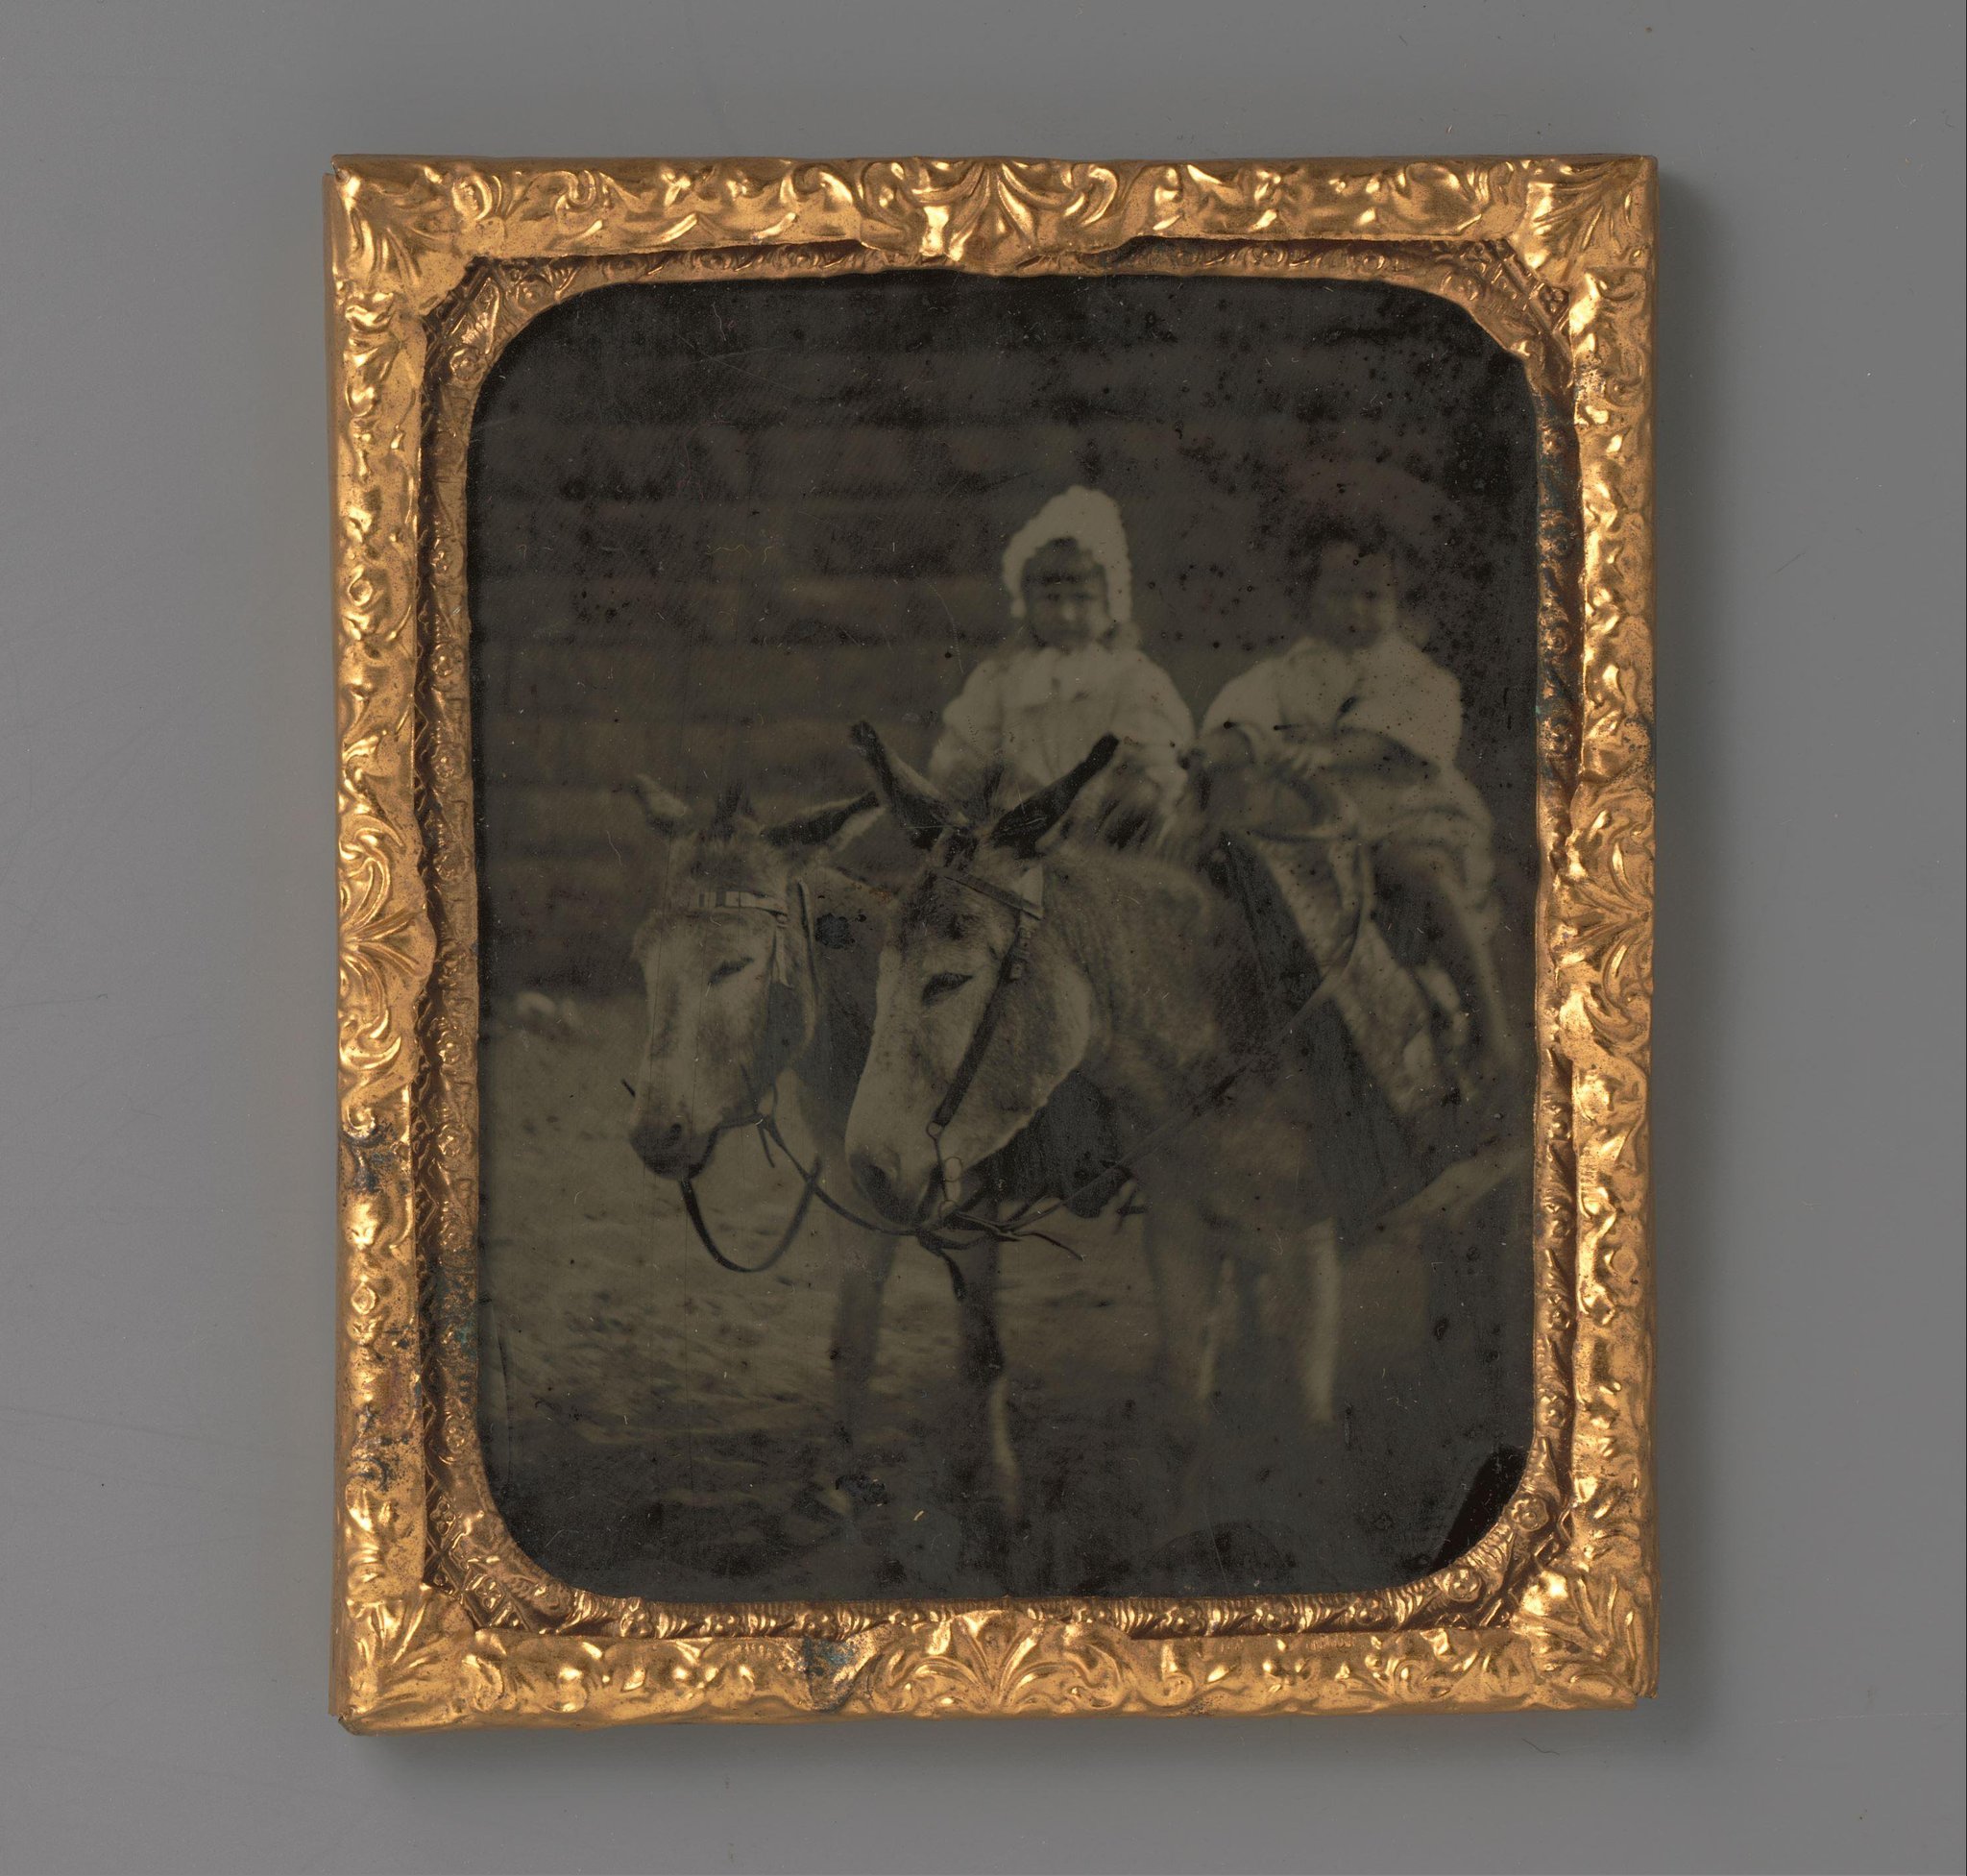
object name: frame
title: Portret van twee onbekende kinderen op ezels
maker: Anonymous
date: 1855-1870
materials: glass, metal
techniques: ambrotype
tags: ass, donkey, historical persons, child between toddler and youth (of undetermined sex) (+ two persons)